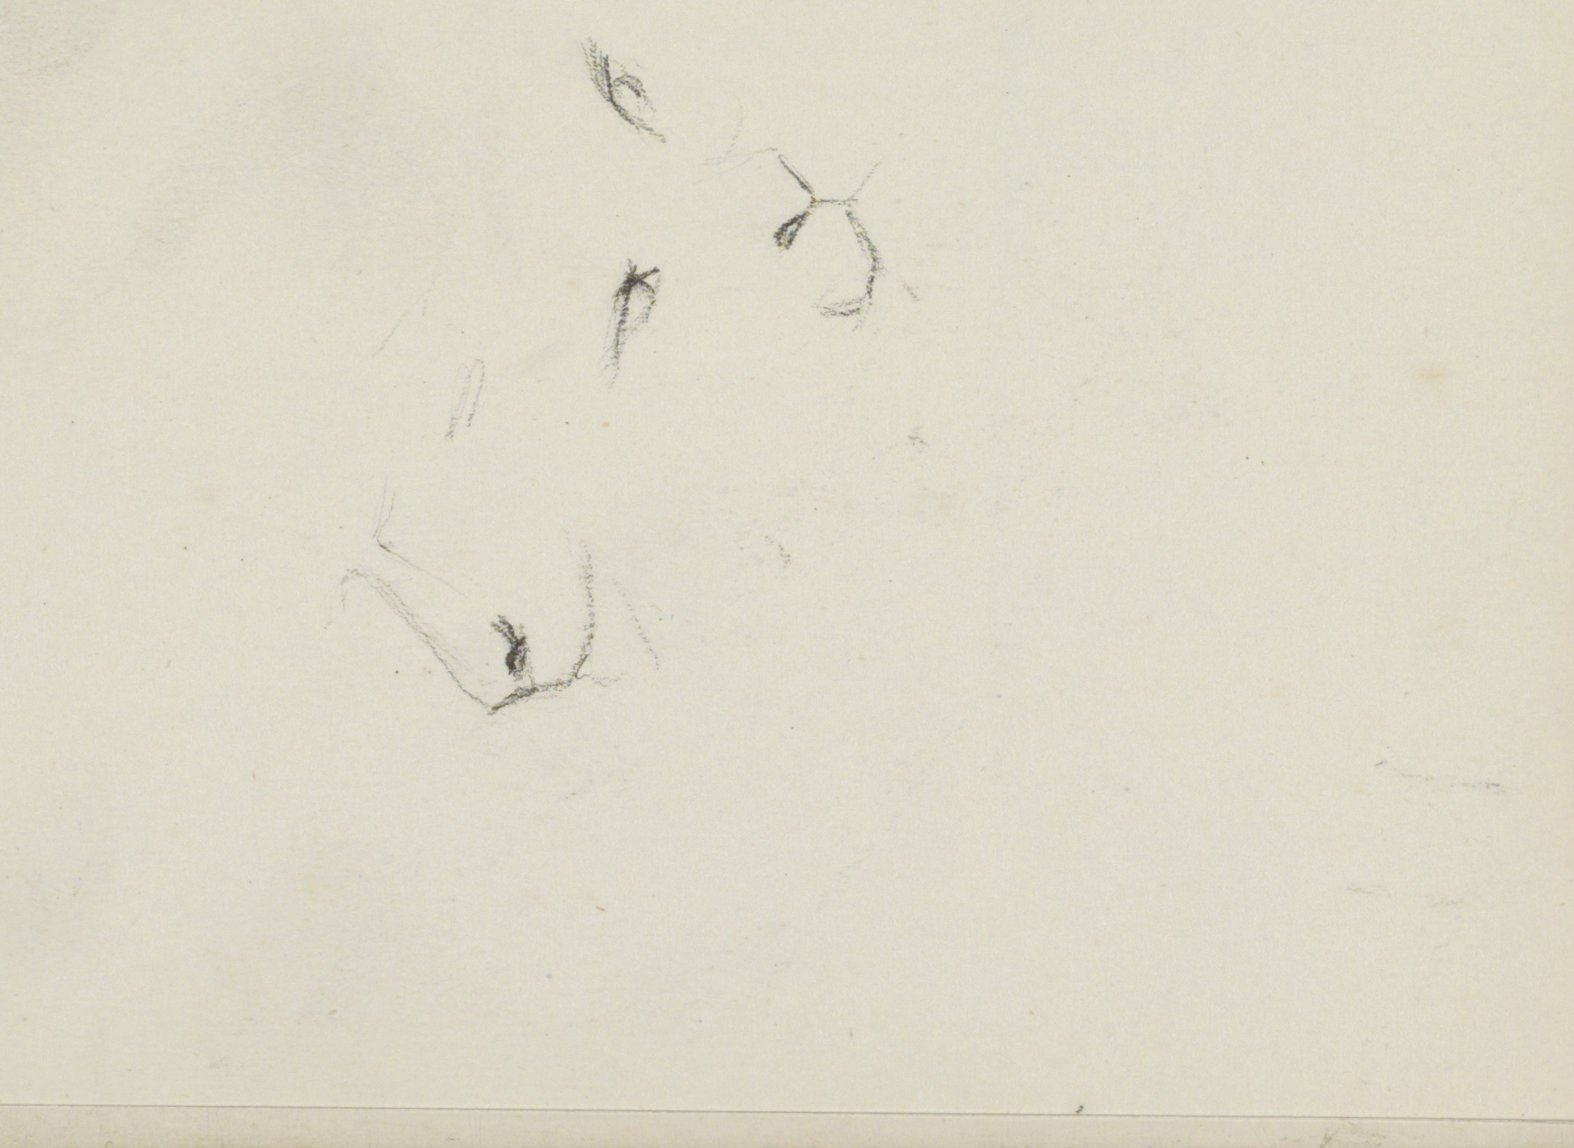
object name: sketchbook leaf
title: Snuit van een leeuw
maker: a.a.l. de grammont-hubrecht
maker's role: draughtsman, painter, print maker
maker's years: 1855-1913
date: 1865-1913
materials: chalk, paper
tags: beasts of prey, predatory animals: lion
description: Blad 32 recto uit een schetsboek met 38 bladen.